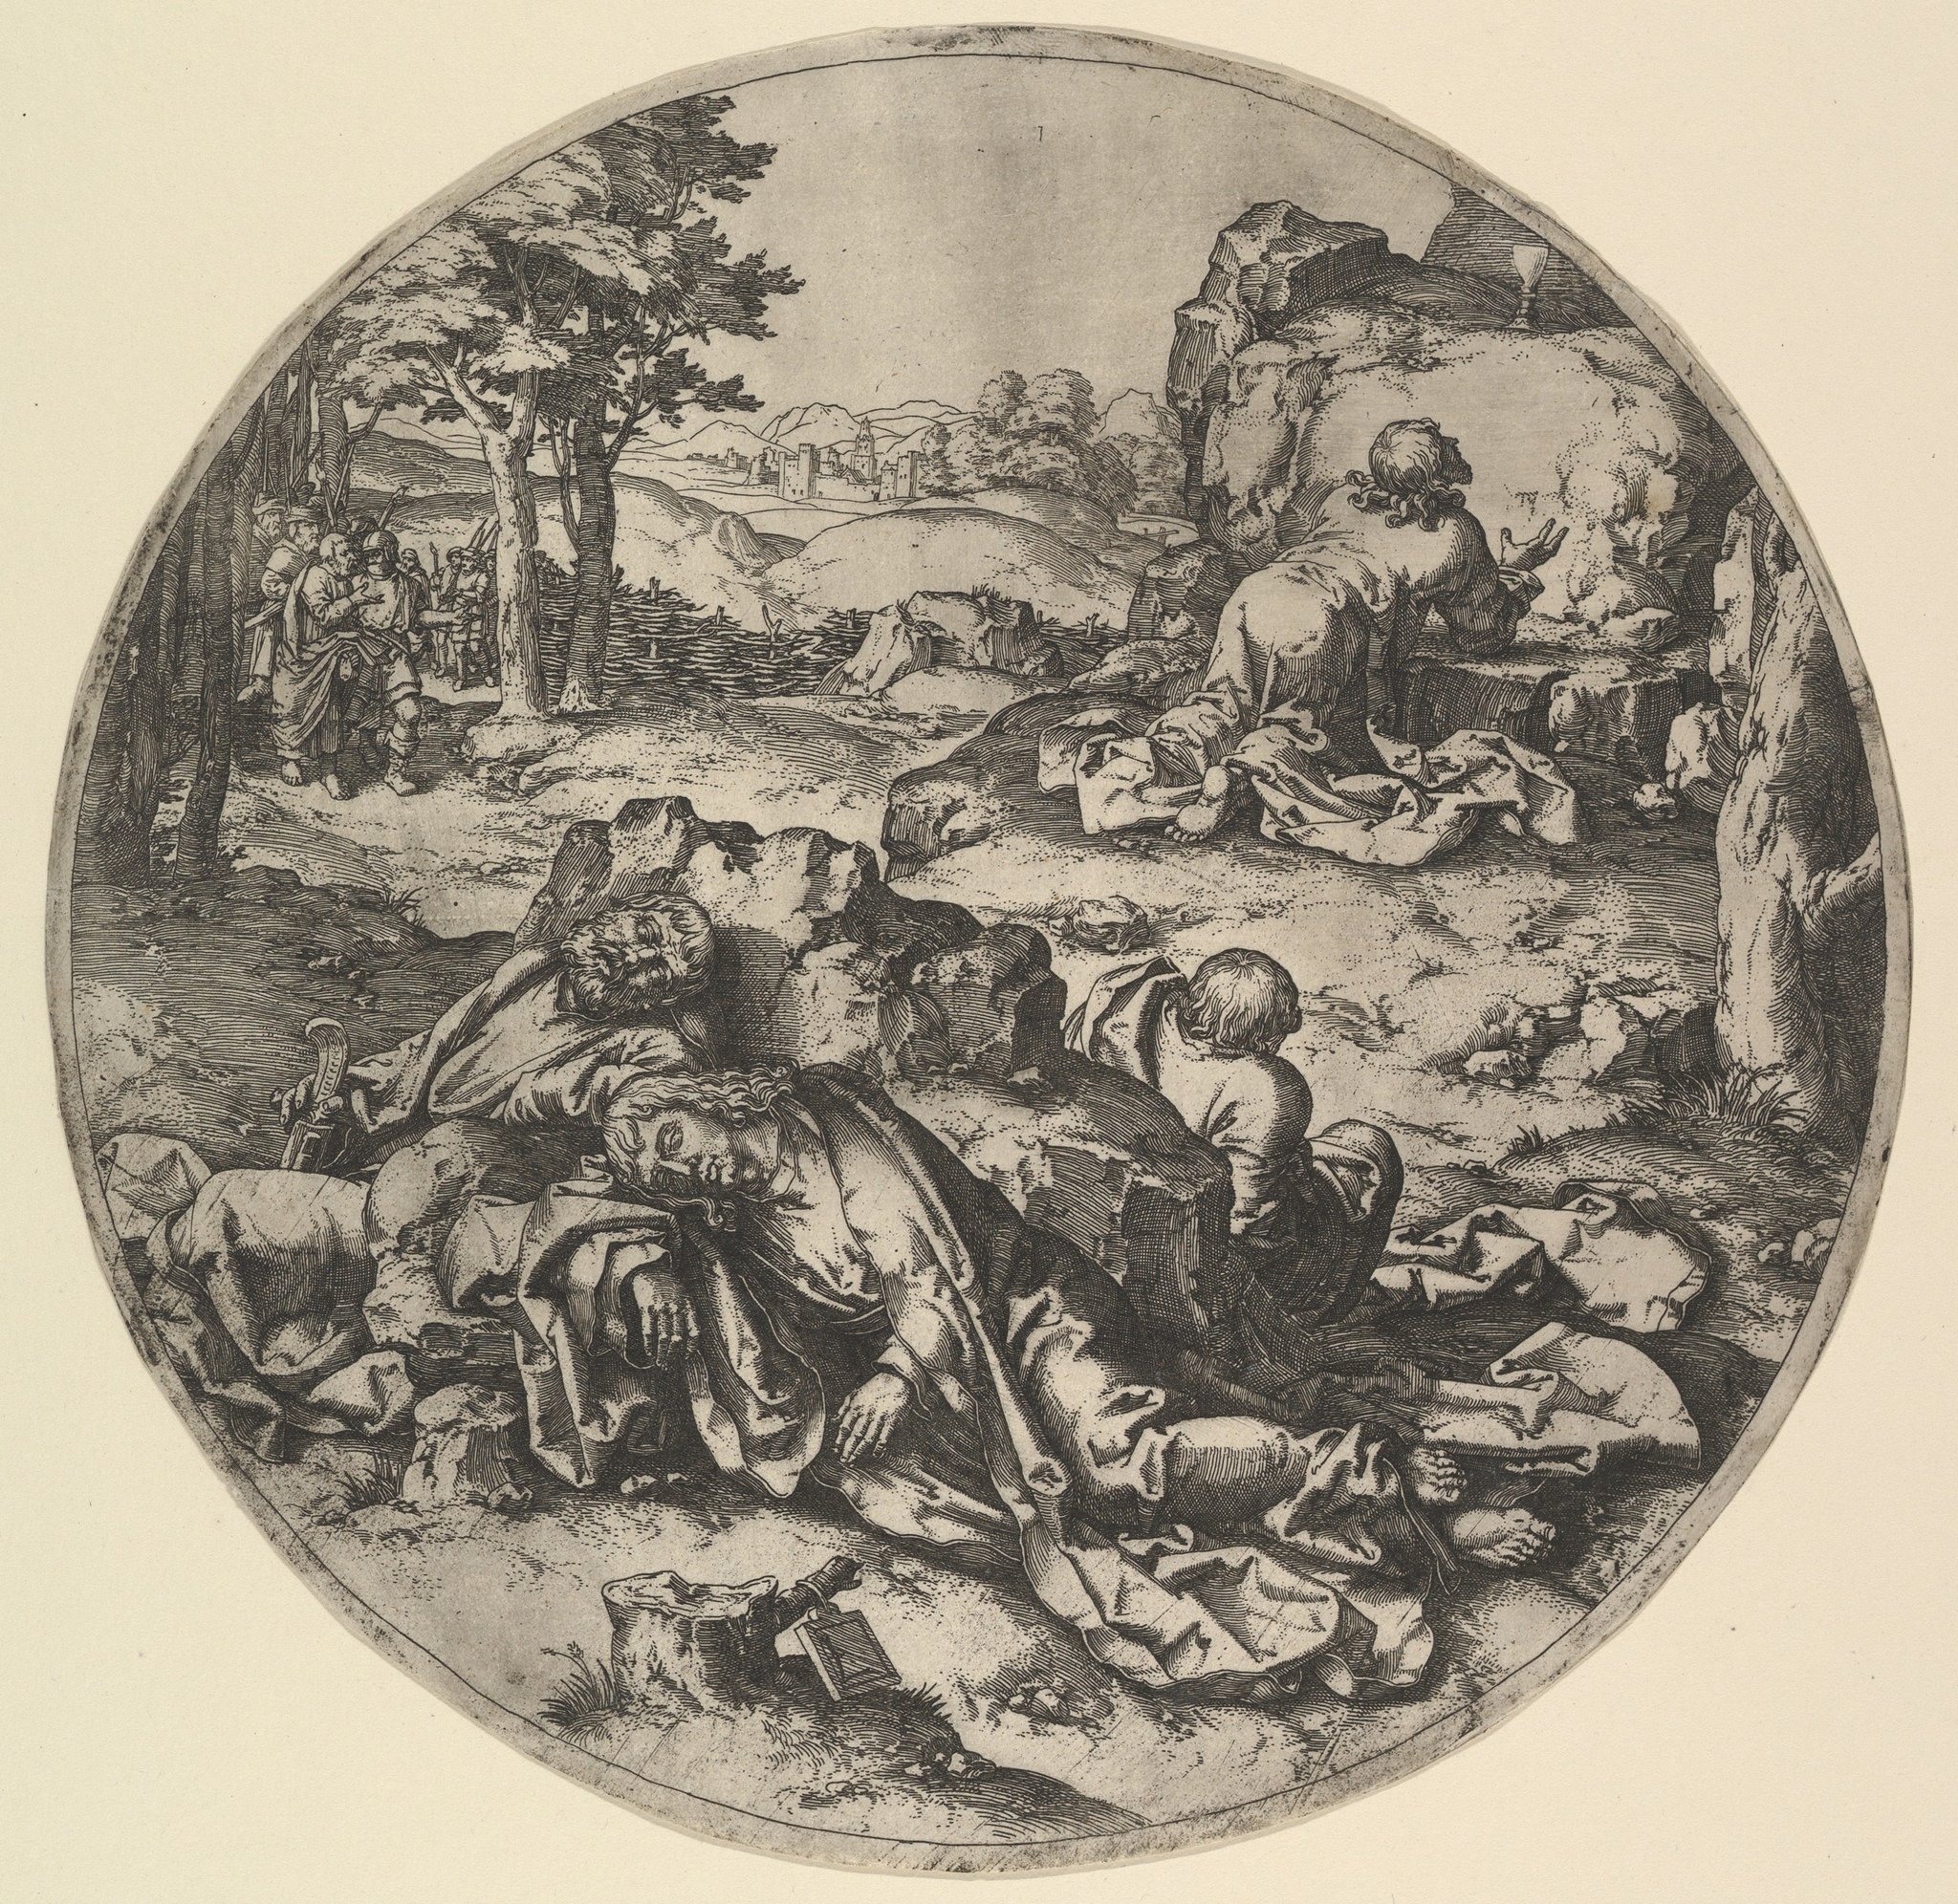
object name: print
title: Christ in Gethsemane (copy)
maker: claes jansz. visscher (ii)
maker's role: artist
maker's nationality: dutch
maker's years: 1586-1652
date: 1601-1700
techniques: etching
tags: men,trees,christ